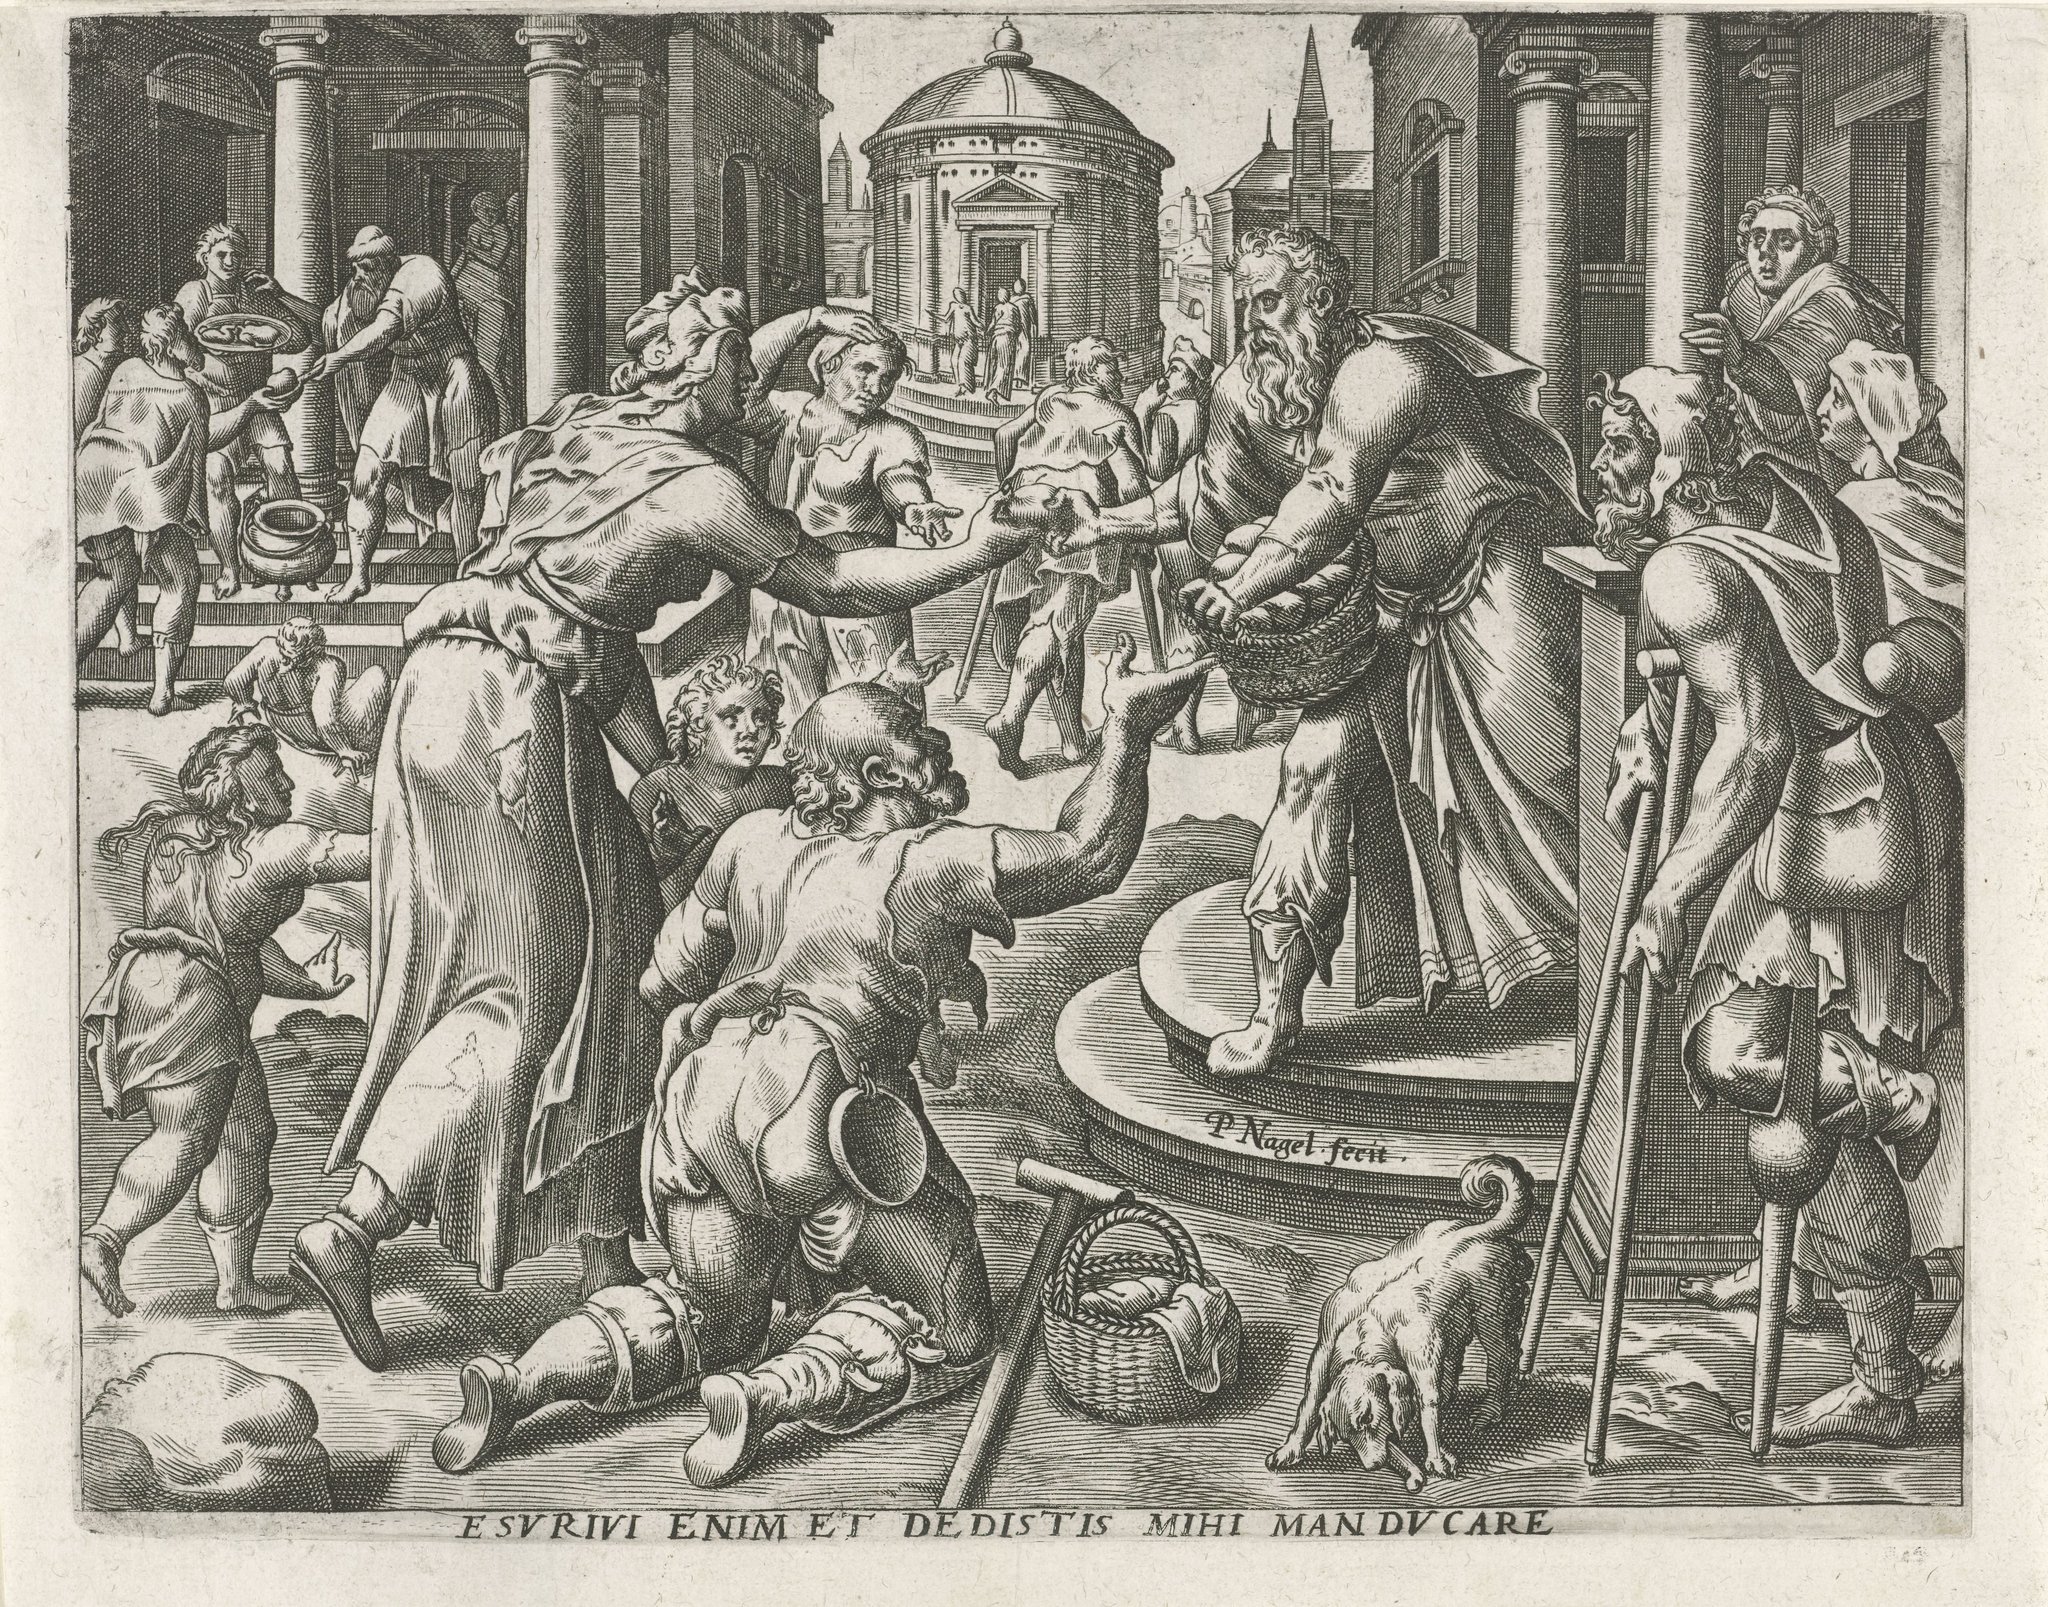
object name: print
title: Werken van barmhartigheid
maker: pieter nagel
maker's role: print maker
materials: paper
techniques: engraving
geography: antwerp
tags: feeding the hungry, 'esuriens cibatur' ~ one of the (seven) acts of mercy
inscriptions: collector's mark: Lugt 2760, collector's mark: Lugt 2228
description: Een man, staand bovenaan een trap, deelt brood uit een mand aan de hongerigen. Links wordt eveneens eten uitgedeeld. Op de achtergrond staat een rond gebouw. Onderaan in de marge een regel tekst in het Latijn. Prent uit een serie over de werken van barmhartigheid.